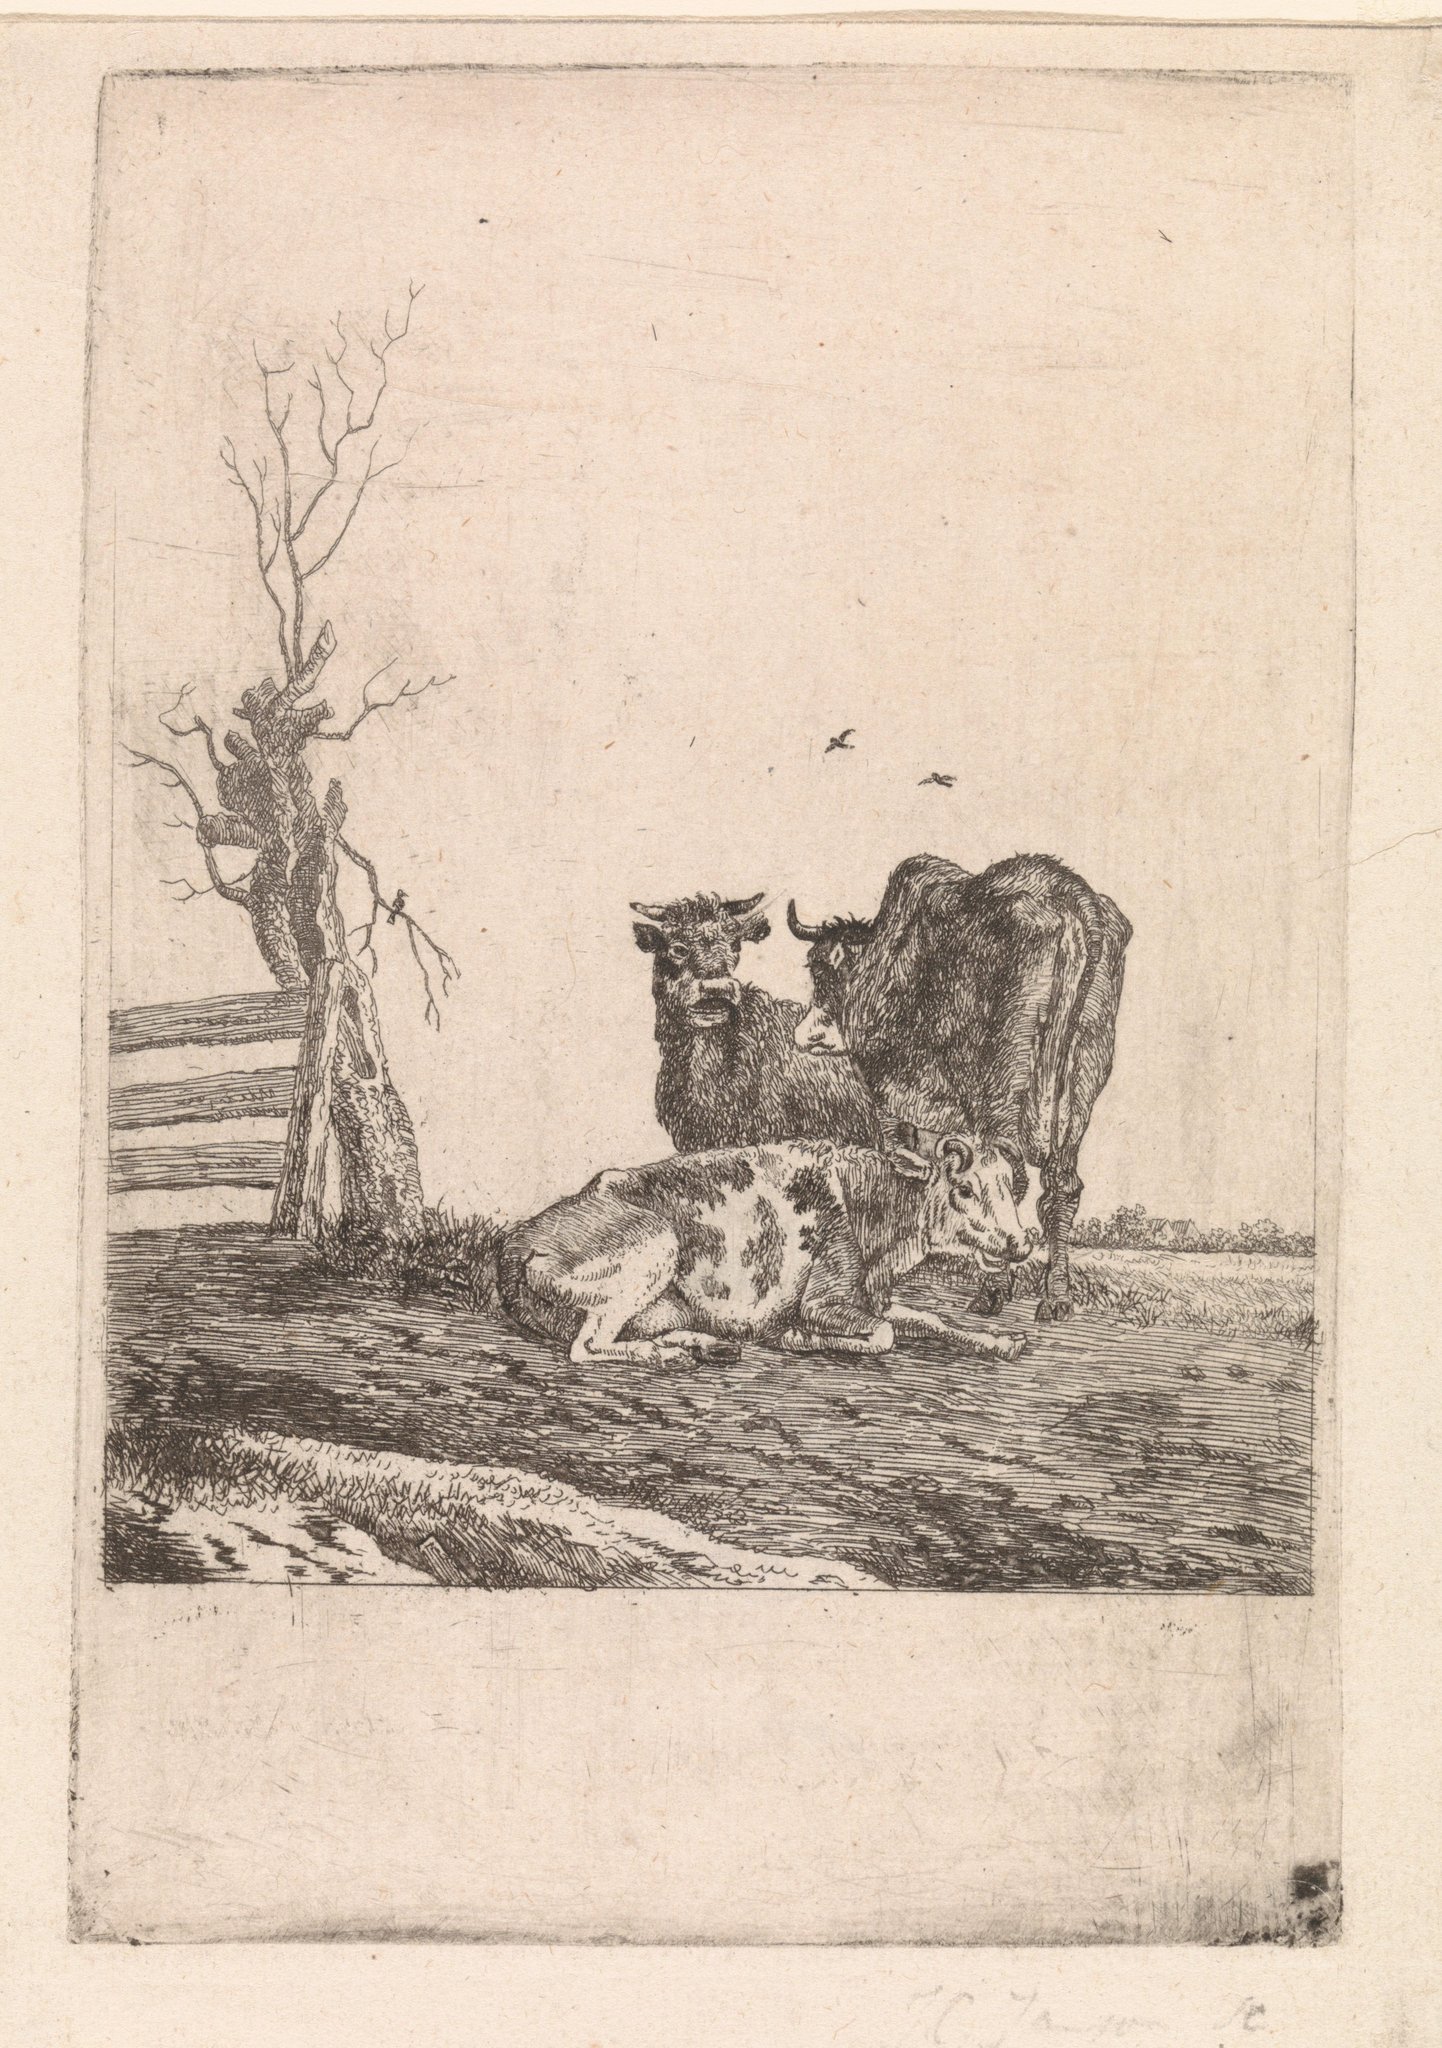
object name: print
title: Landschap met drie koeien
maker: pieter janson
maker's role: draughtsman, print maker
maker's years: 1765-1851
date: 1780-1851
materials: paper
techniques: etching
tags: cow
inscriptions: collector's mark: Lugt 2228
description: Landschap met liggende koe, naar rechts, en twee staande koeien. Links een wilg bij een hek. Onder de voorstelling een lege marge.